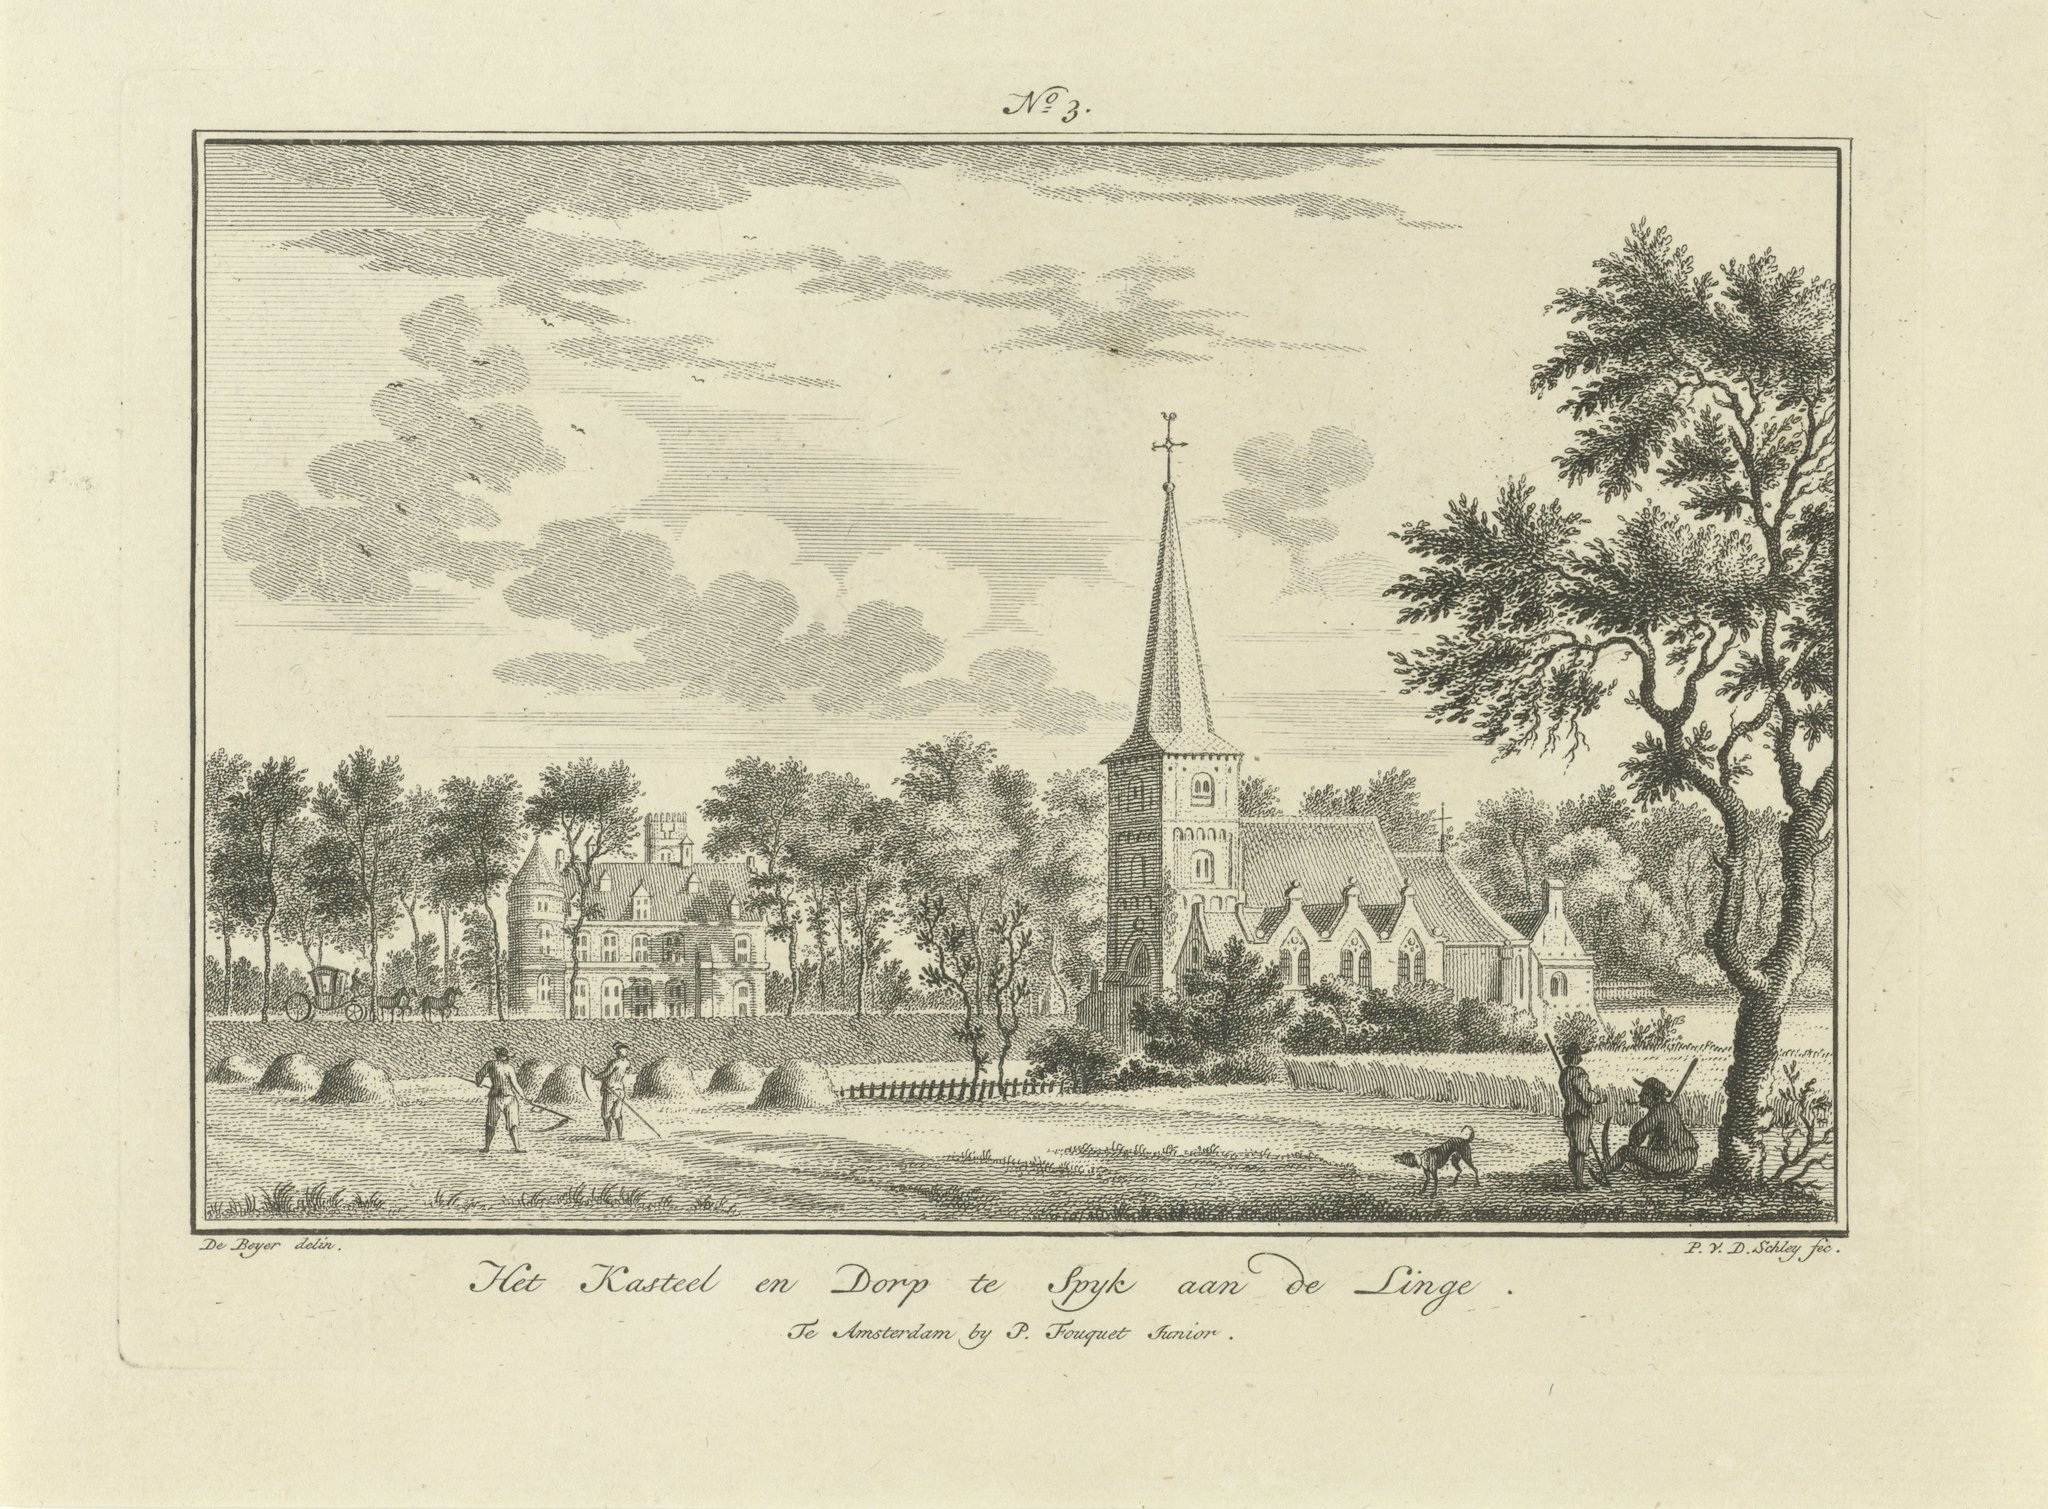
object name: print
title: Kasteel en kerk te Spijk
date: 1760-1796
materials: paper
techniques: etching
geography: netherlands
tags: castle, farmers, church (exterior)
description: Gezicht op het kasteel en de kerk te Spijk (Lingewaal), met op de voorgrond enkele landarbeiders die op een akker werken. Op de dijk voor het kasteel rijdt een koets.